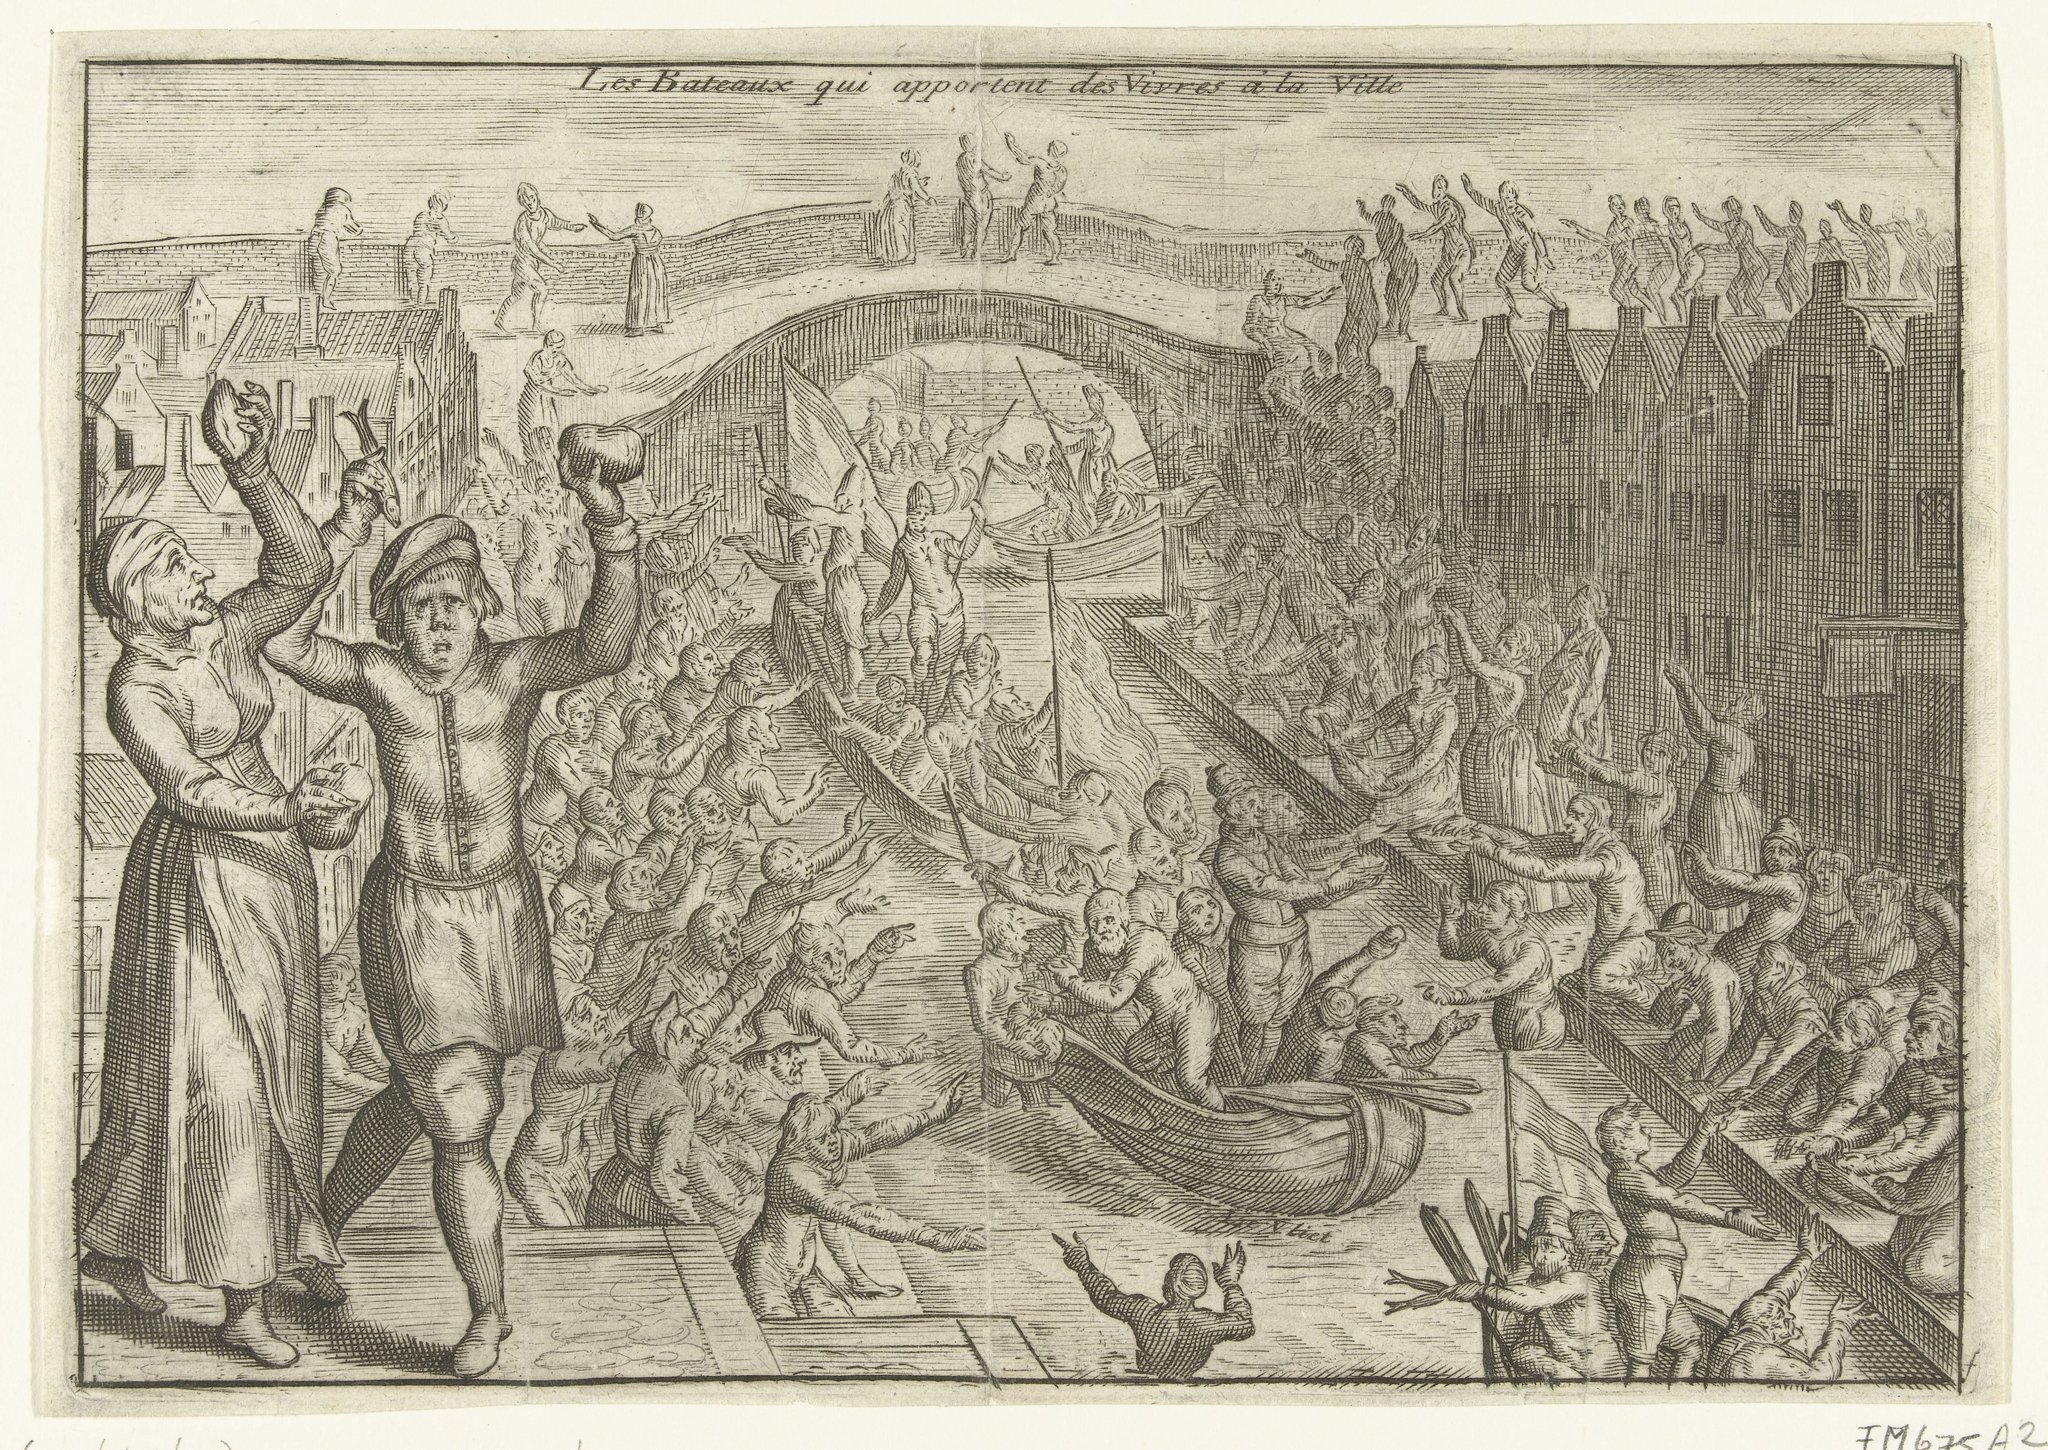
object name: print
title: Les bateaux qui apportent des Vivres à la Ville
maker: willem de haen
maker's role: draughtsman, print maker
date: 1612-1614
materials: paper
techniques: engraving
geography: northern netherlands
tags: leiden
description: Ontzet van Leiden, 3 oktober 1574. Blijdschap onder Leidenaren in de stad, soldaten in boten delen eten uit aan de inwoners die knielen langs de kade van een gracht. Zonder de gebeeldhouwde omlijsting met hermen aan weerszijden. Rechtsonder gemerkt: f.